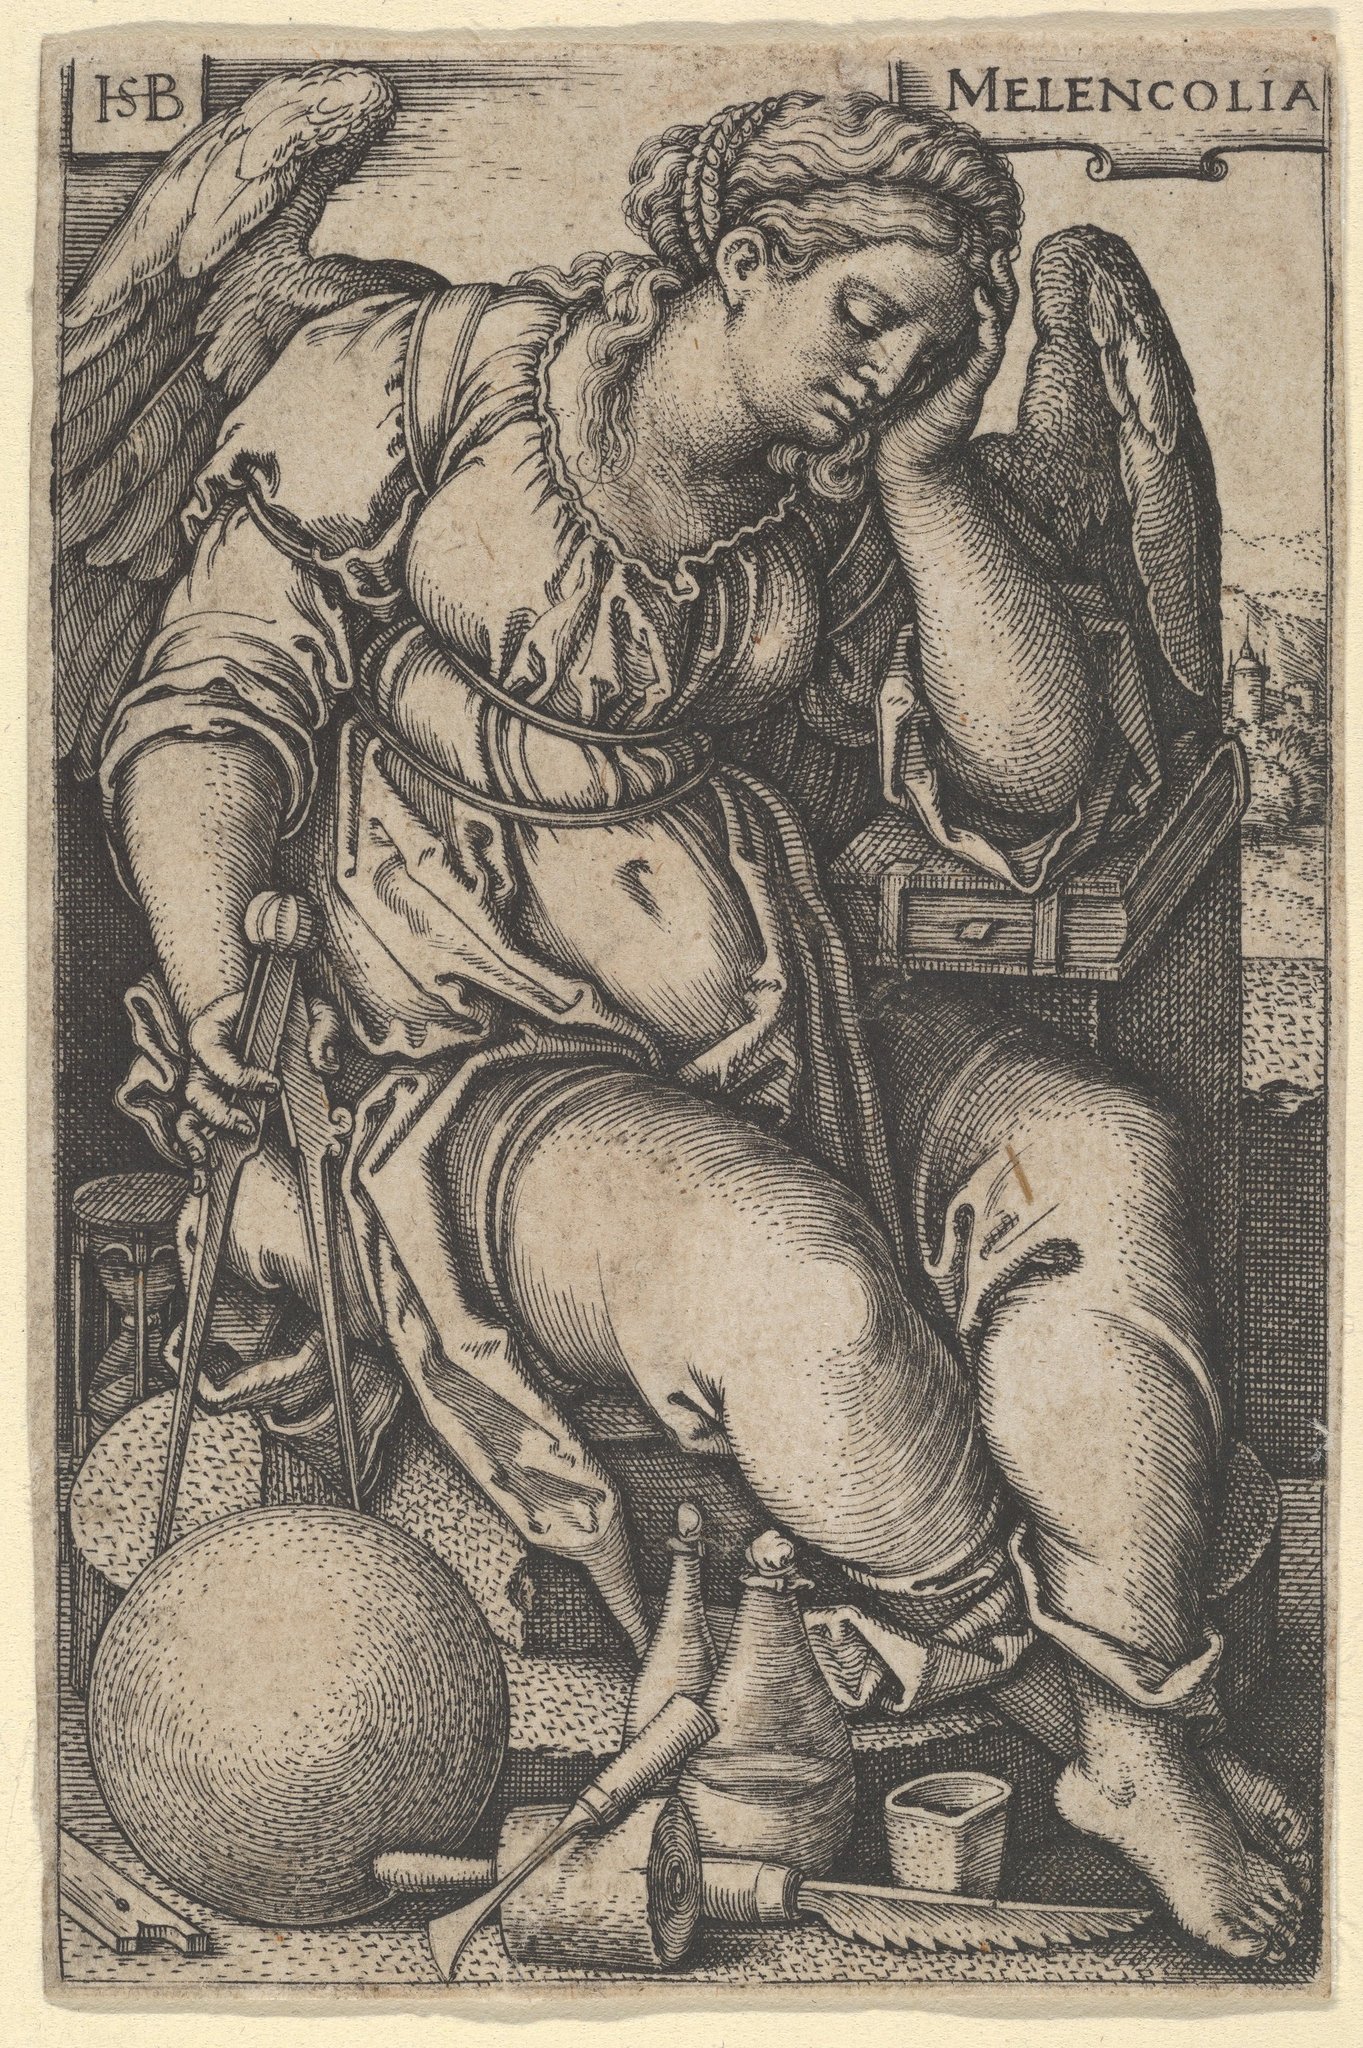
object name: print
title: Melancholia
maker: sebald beham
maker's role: artist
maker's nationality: german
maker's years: 1500-1550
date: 1500-1550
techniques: engraving